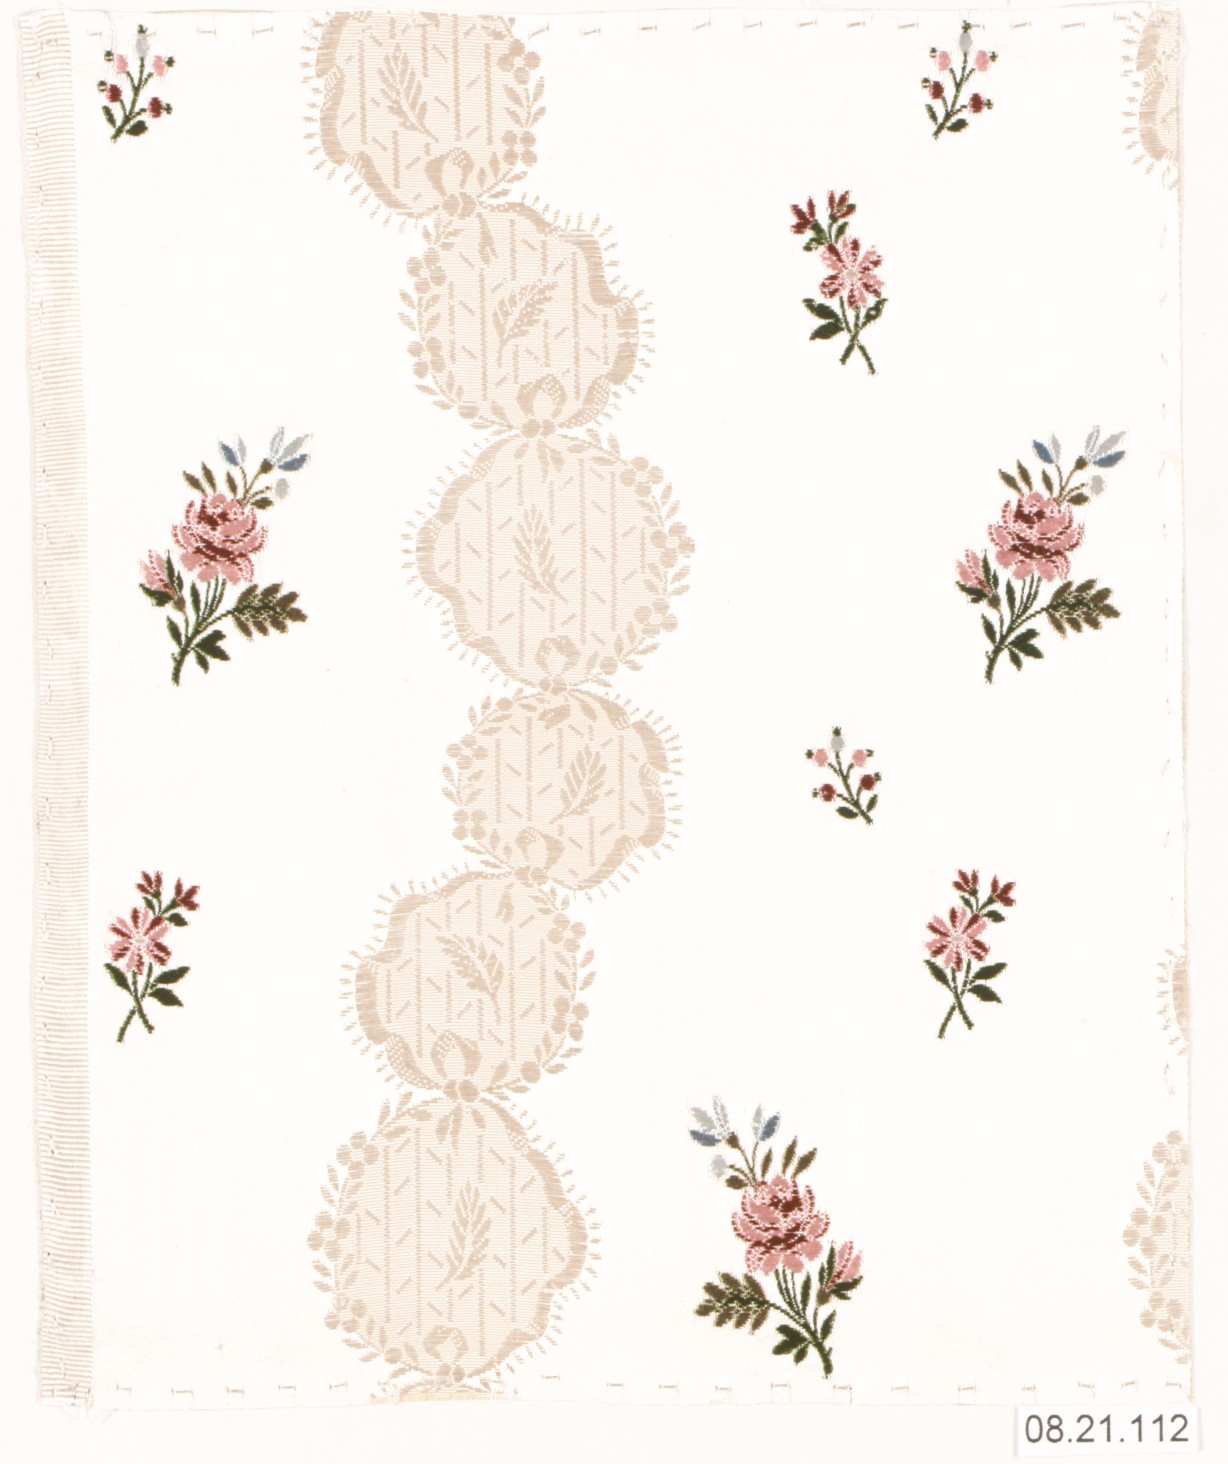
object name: textile sample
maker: Anonymous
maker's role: designer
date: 1900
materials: silk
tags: flowers